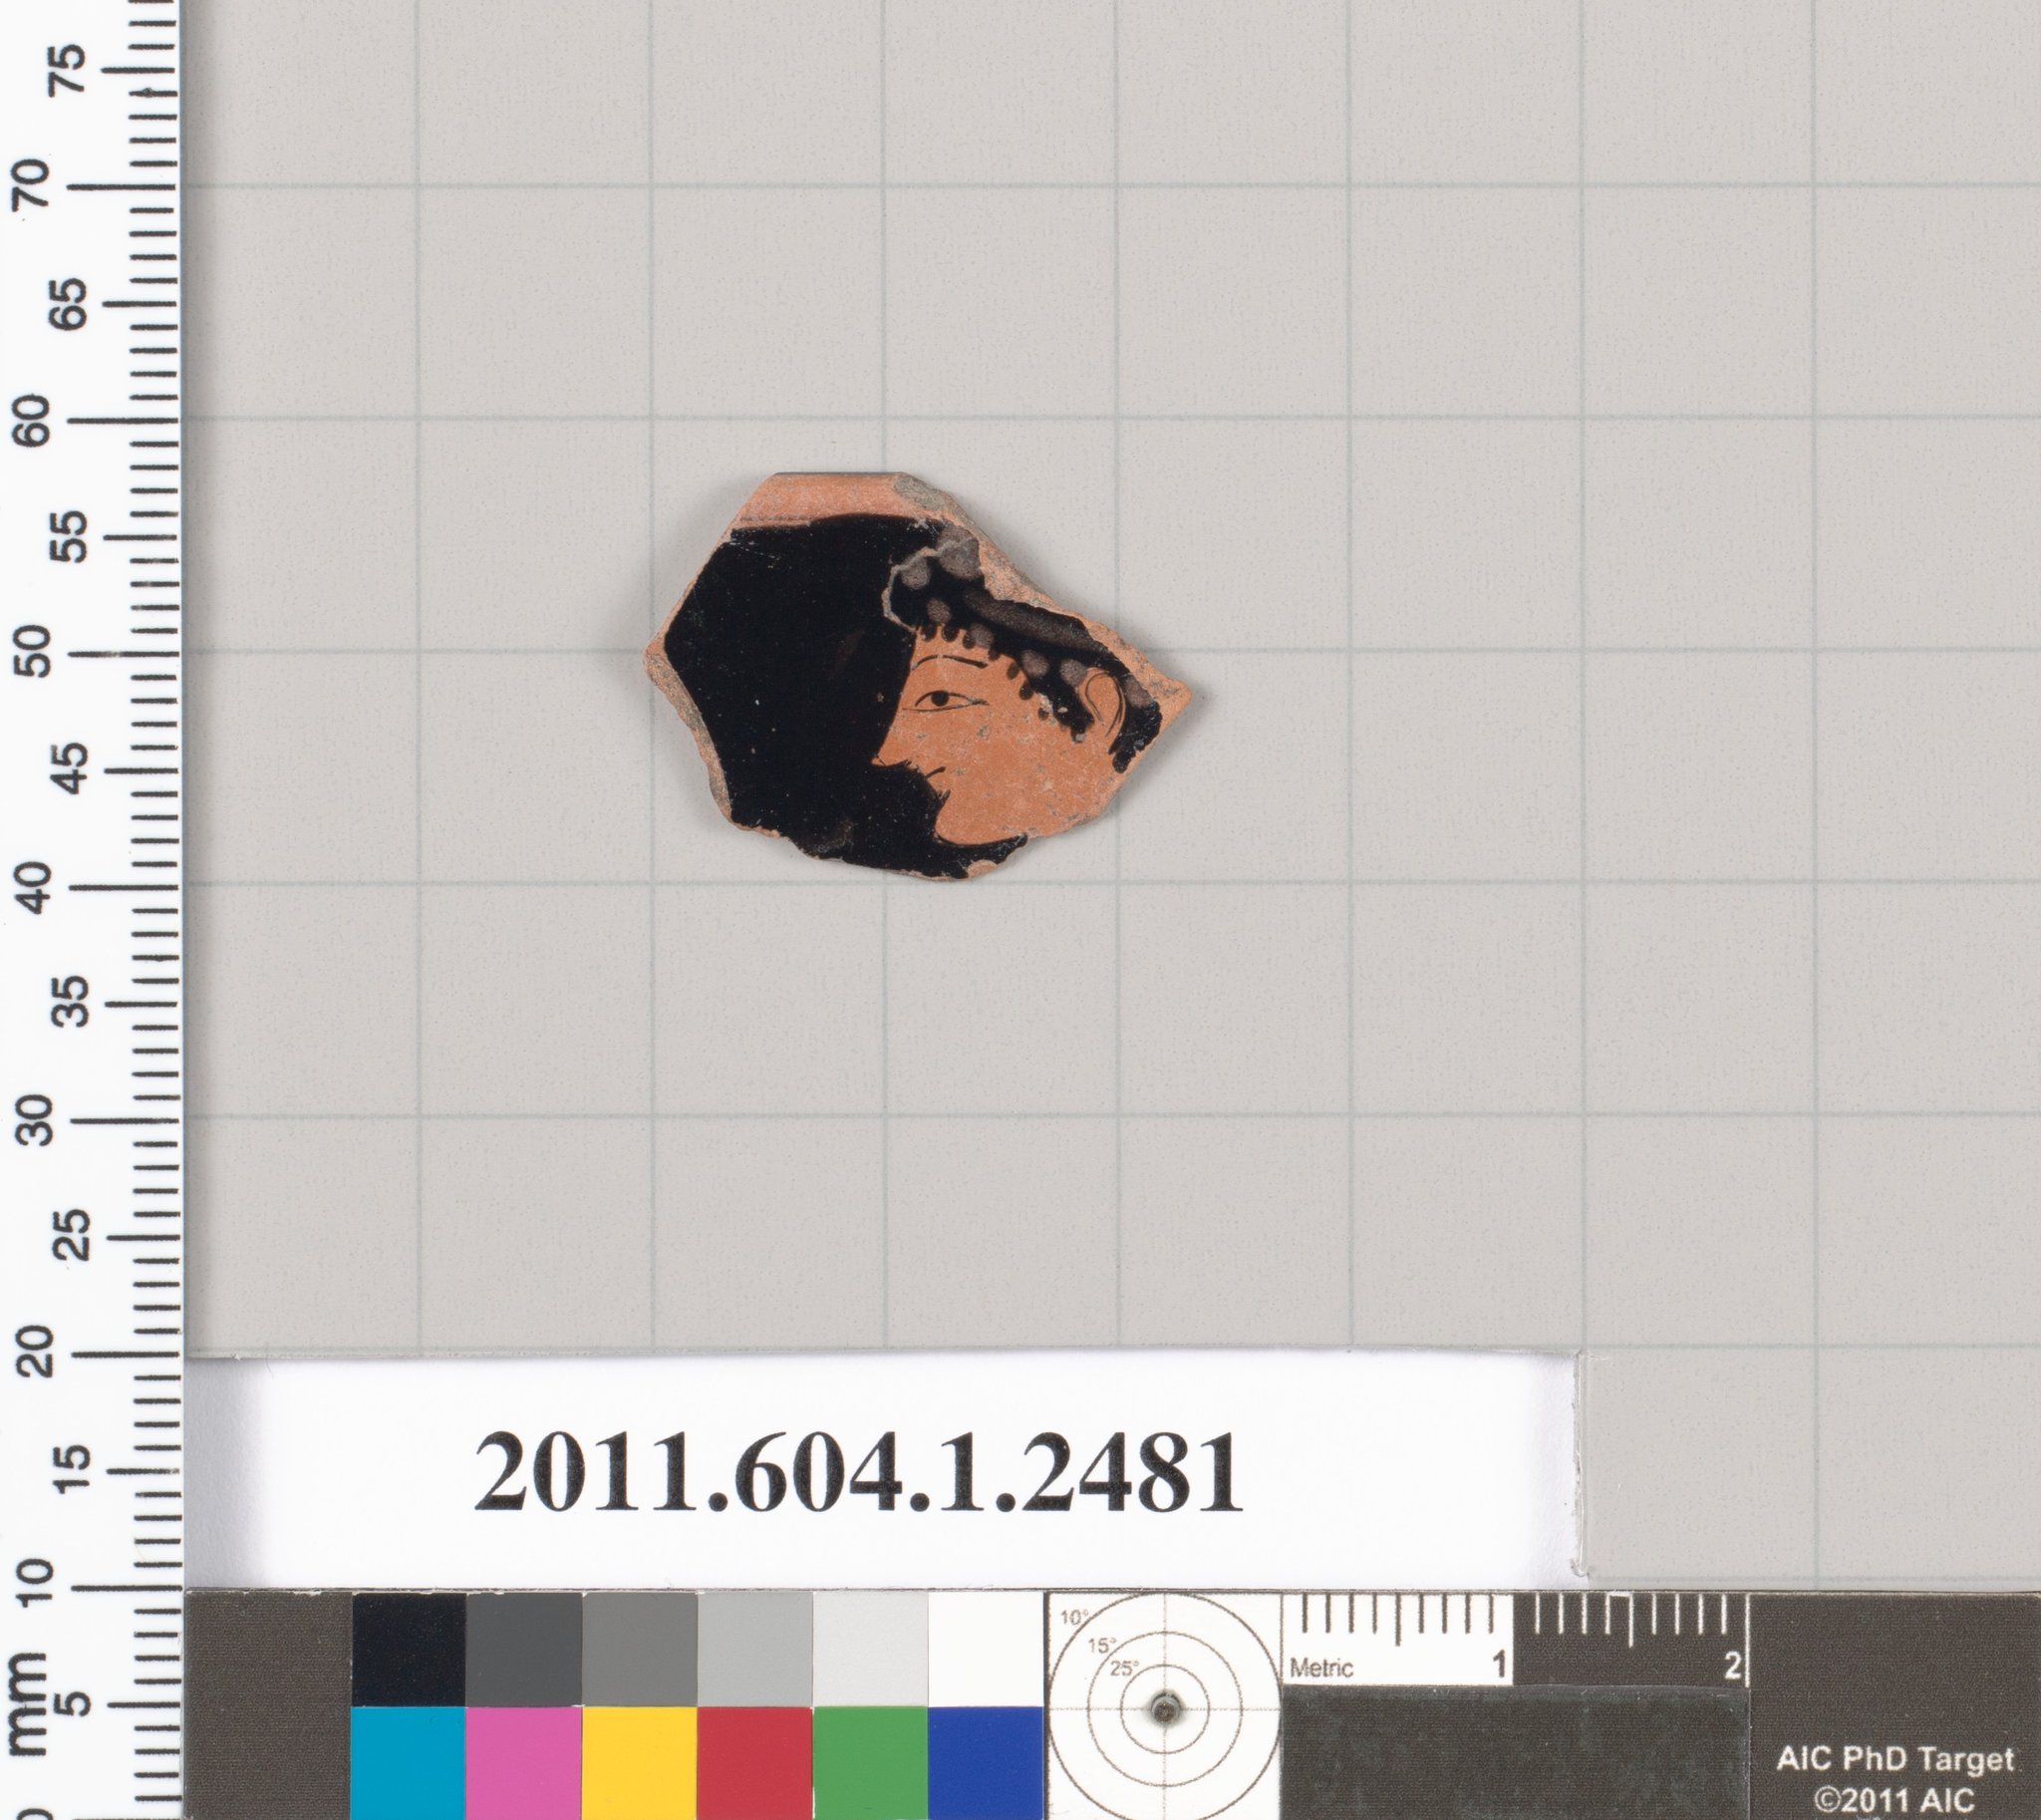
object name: kylix fragment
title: Terracotta rim fragment of a kylix (drinking cup)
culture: greek, attic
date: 520-500 BCE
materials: terracotta